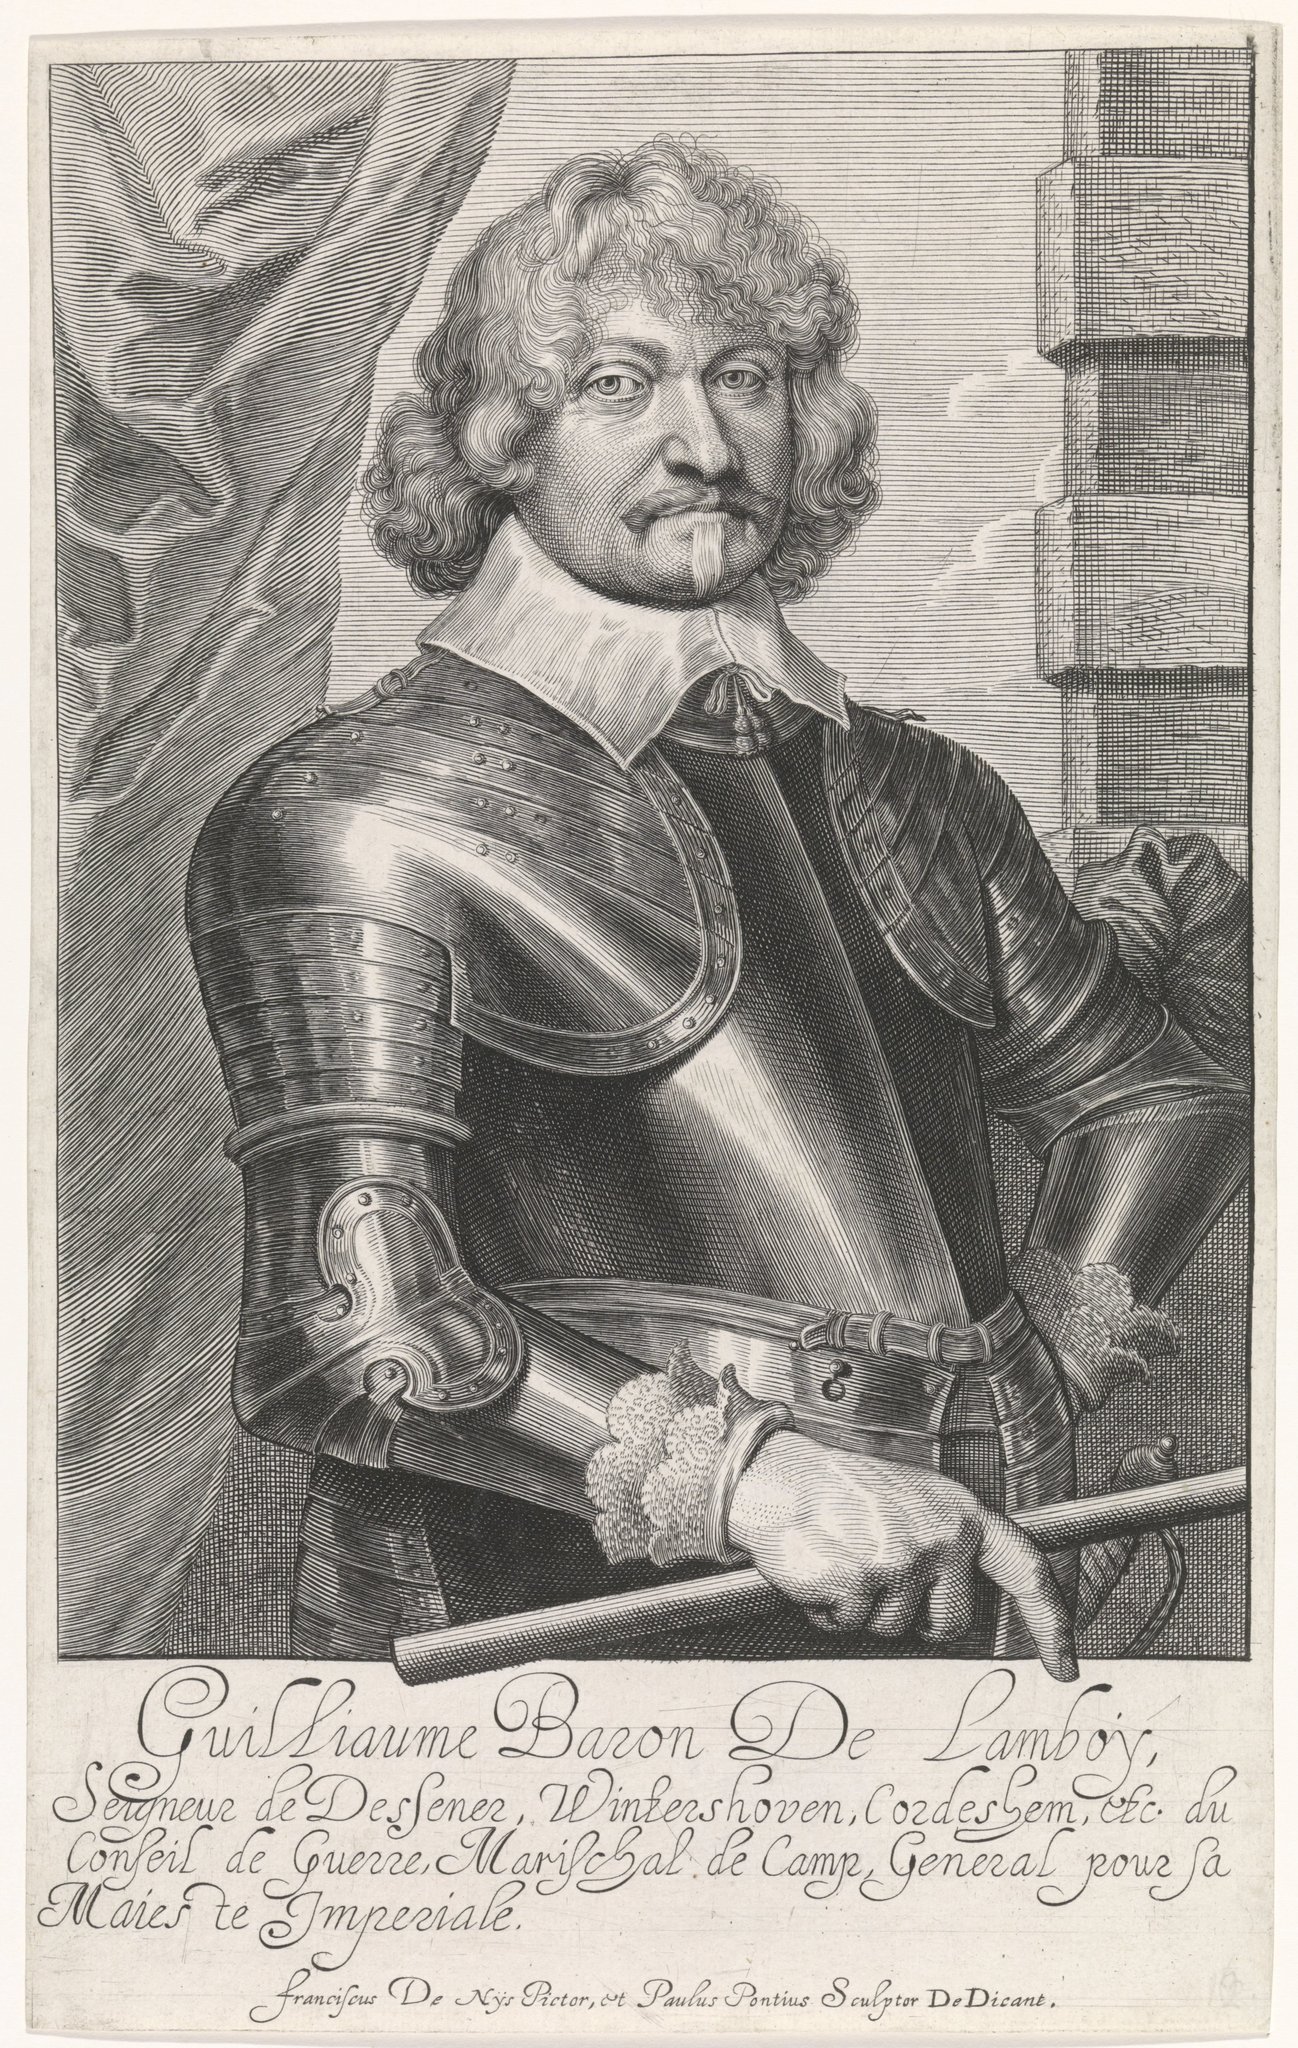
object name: print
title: Portret van Guillaume, baron van Lamboy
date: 1616-1657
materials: paper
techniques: engraving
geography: antwerp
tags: armour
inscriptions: collector's mark: Lugt 2228, collector's mark: Lugt 2760